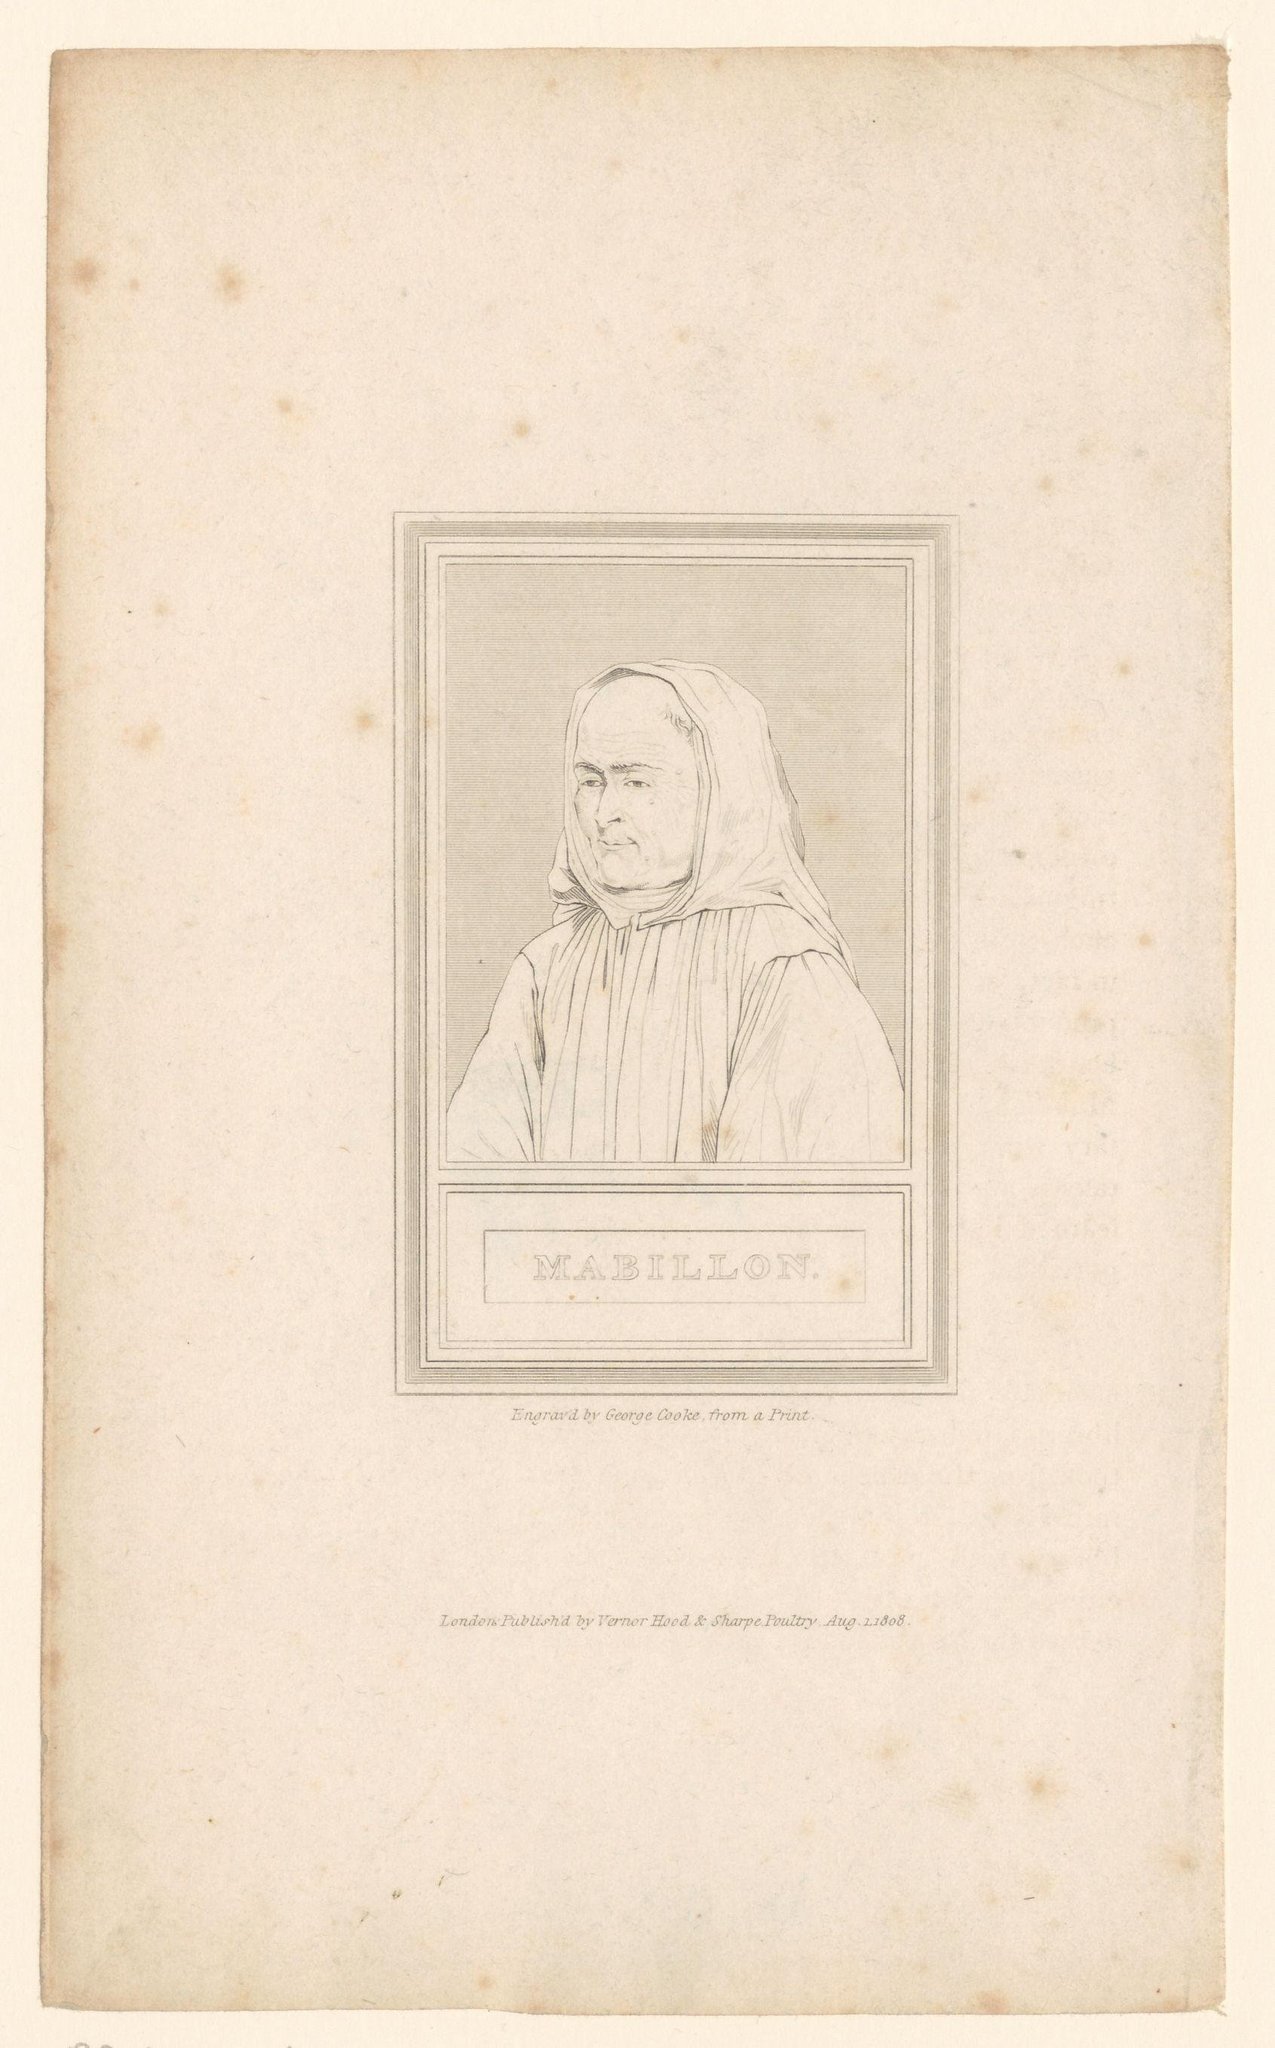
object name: print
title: Mabillon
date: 1808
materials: paper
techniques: etching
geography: london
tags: paris, theologian, historical persons, monk(s), friar(s)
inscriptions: collector's mark: Lugt 2228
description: Prent uit: The Historic Gallery of Portraits and Paintings (...). Londen: Vernor, Hood & Sharpe, 1808.